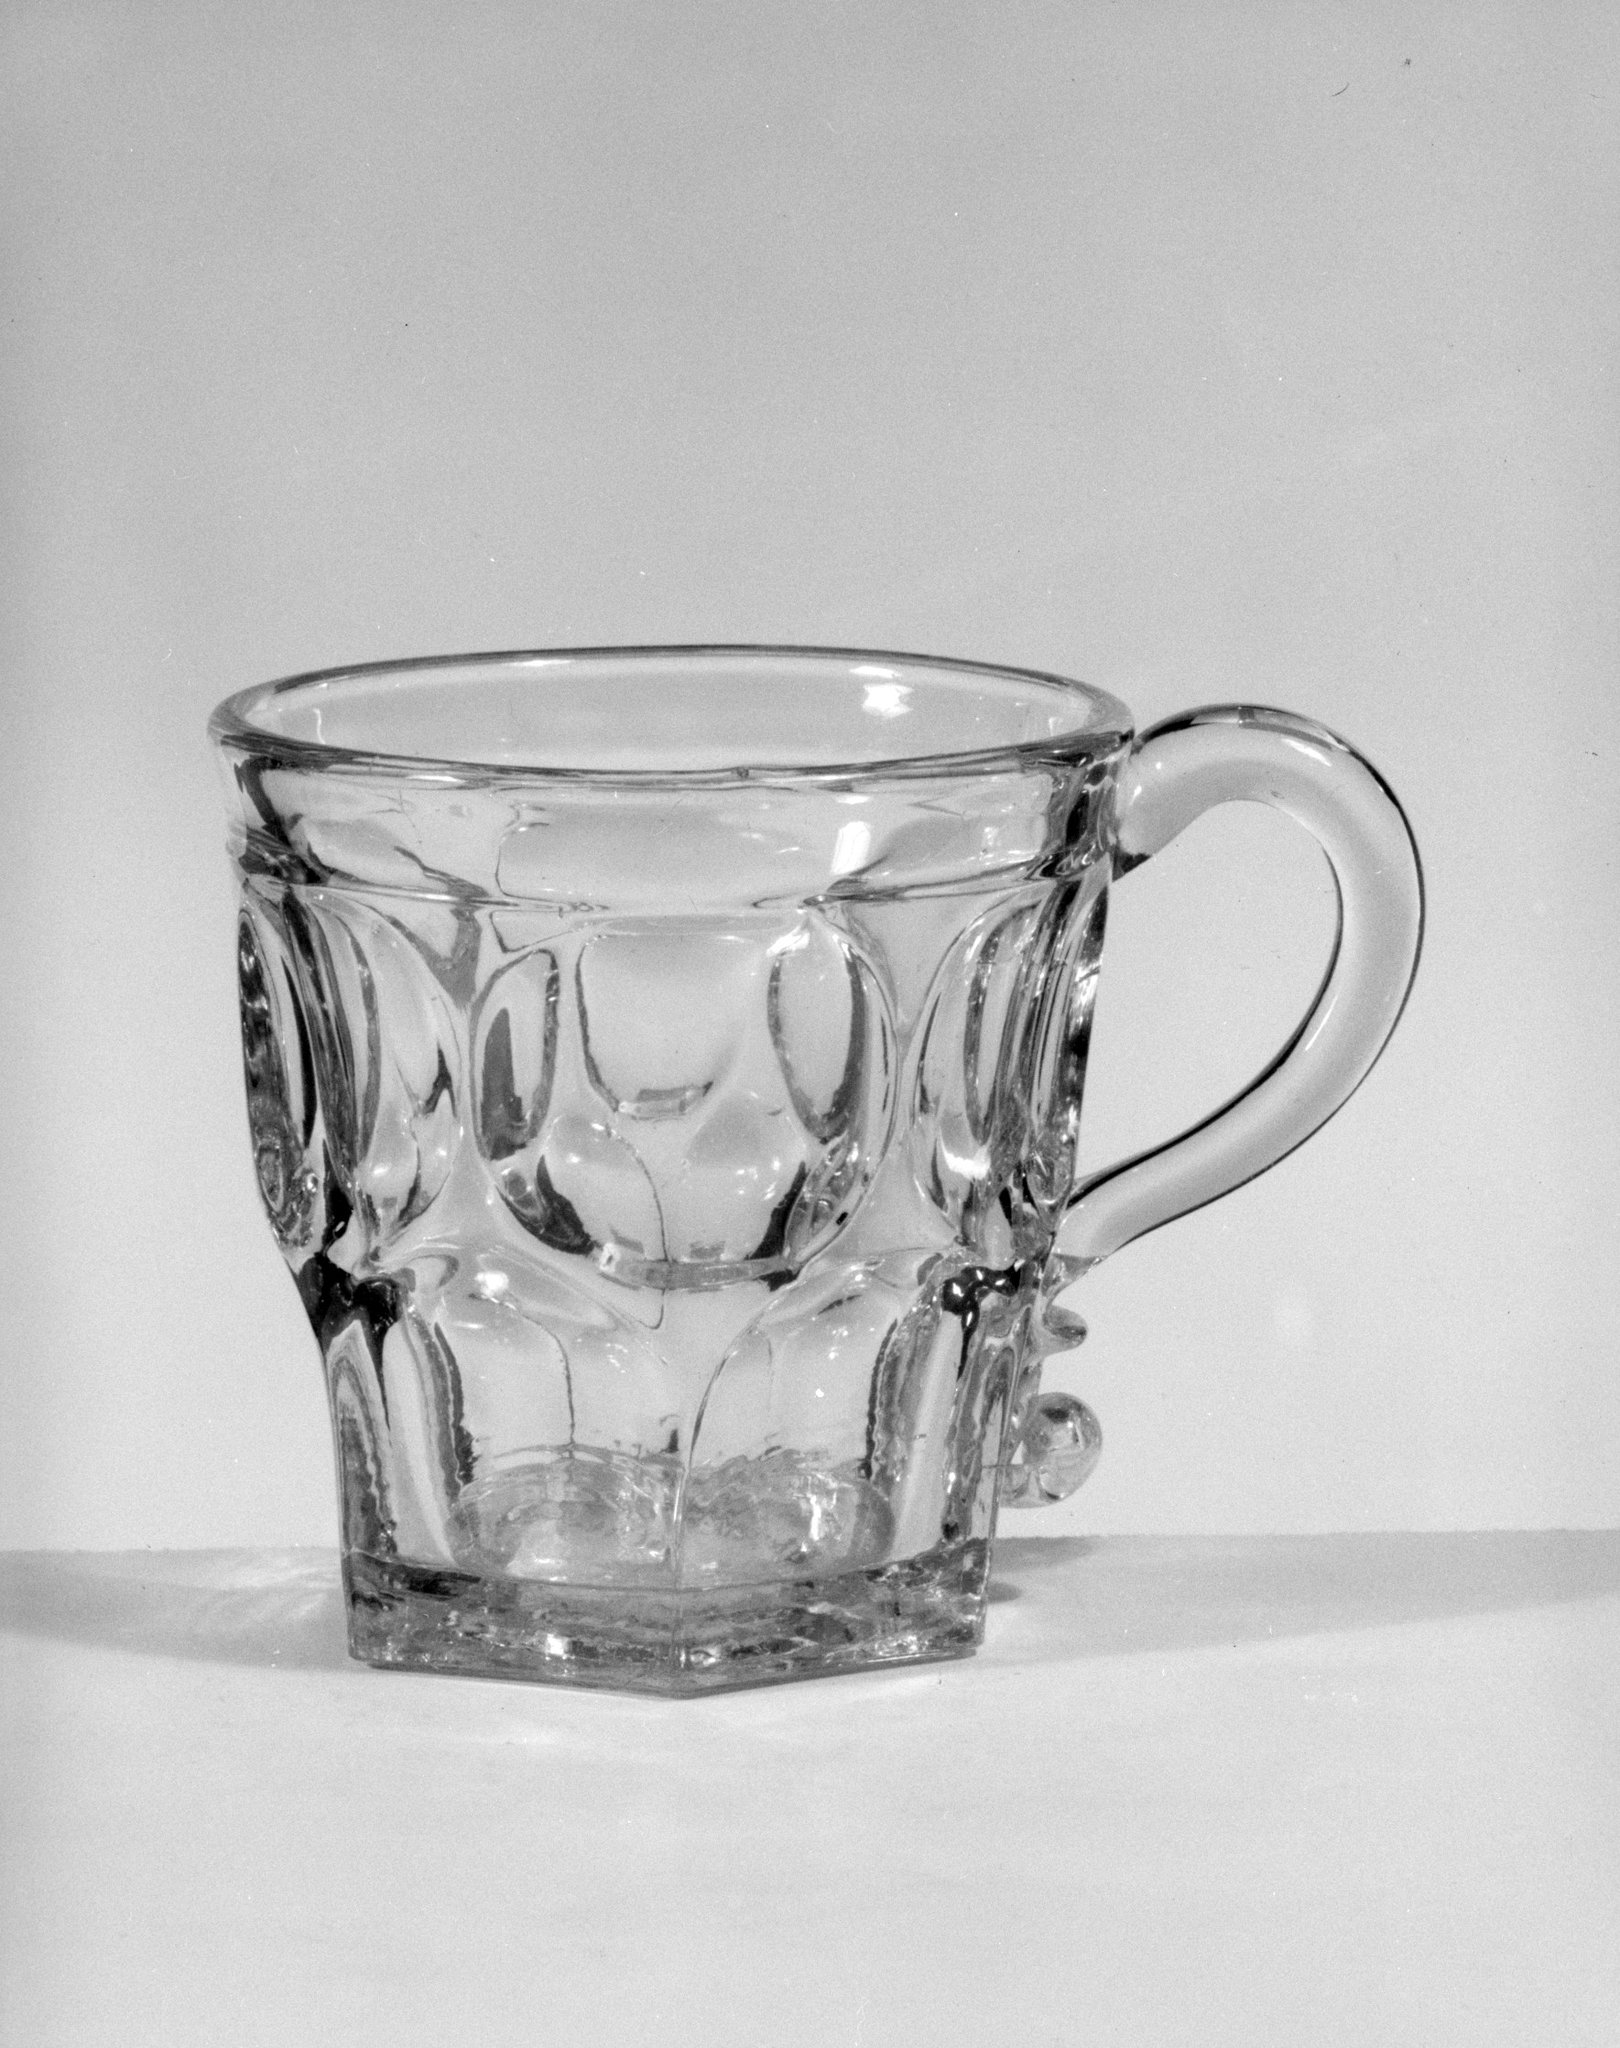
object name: punch glass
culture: american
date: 1830-1870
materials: glass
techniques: pressed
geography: united states